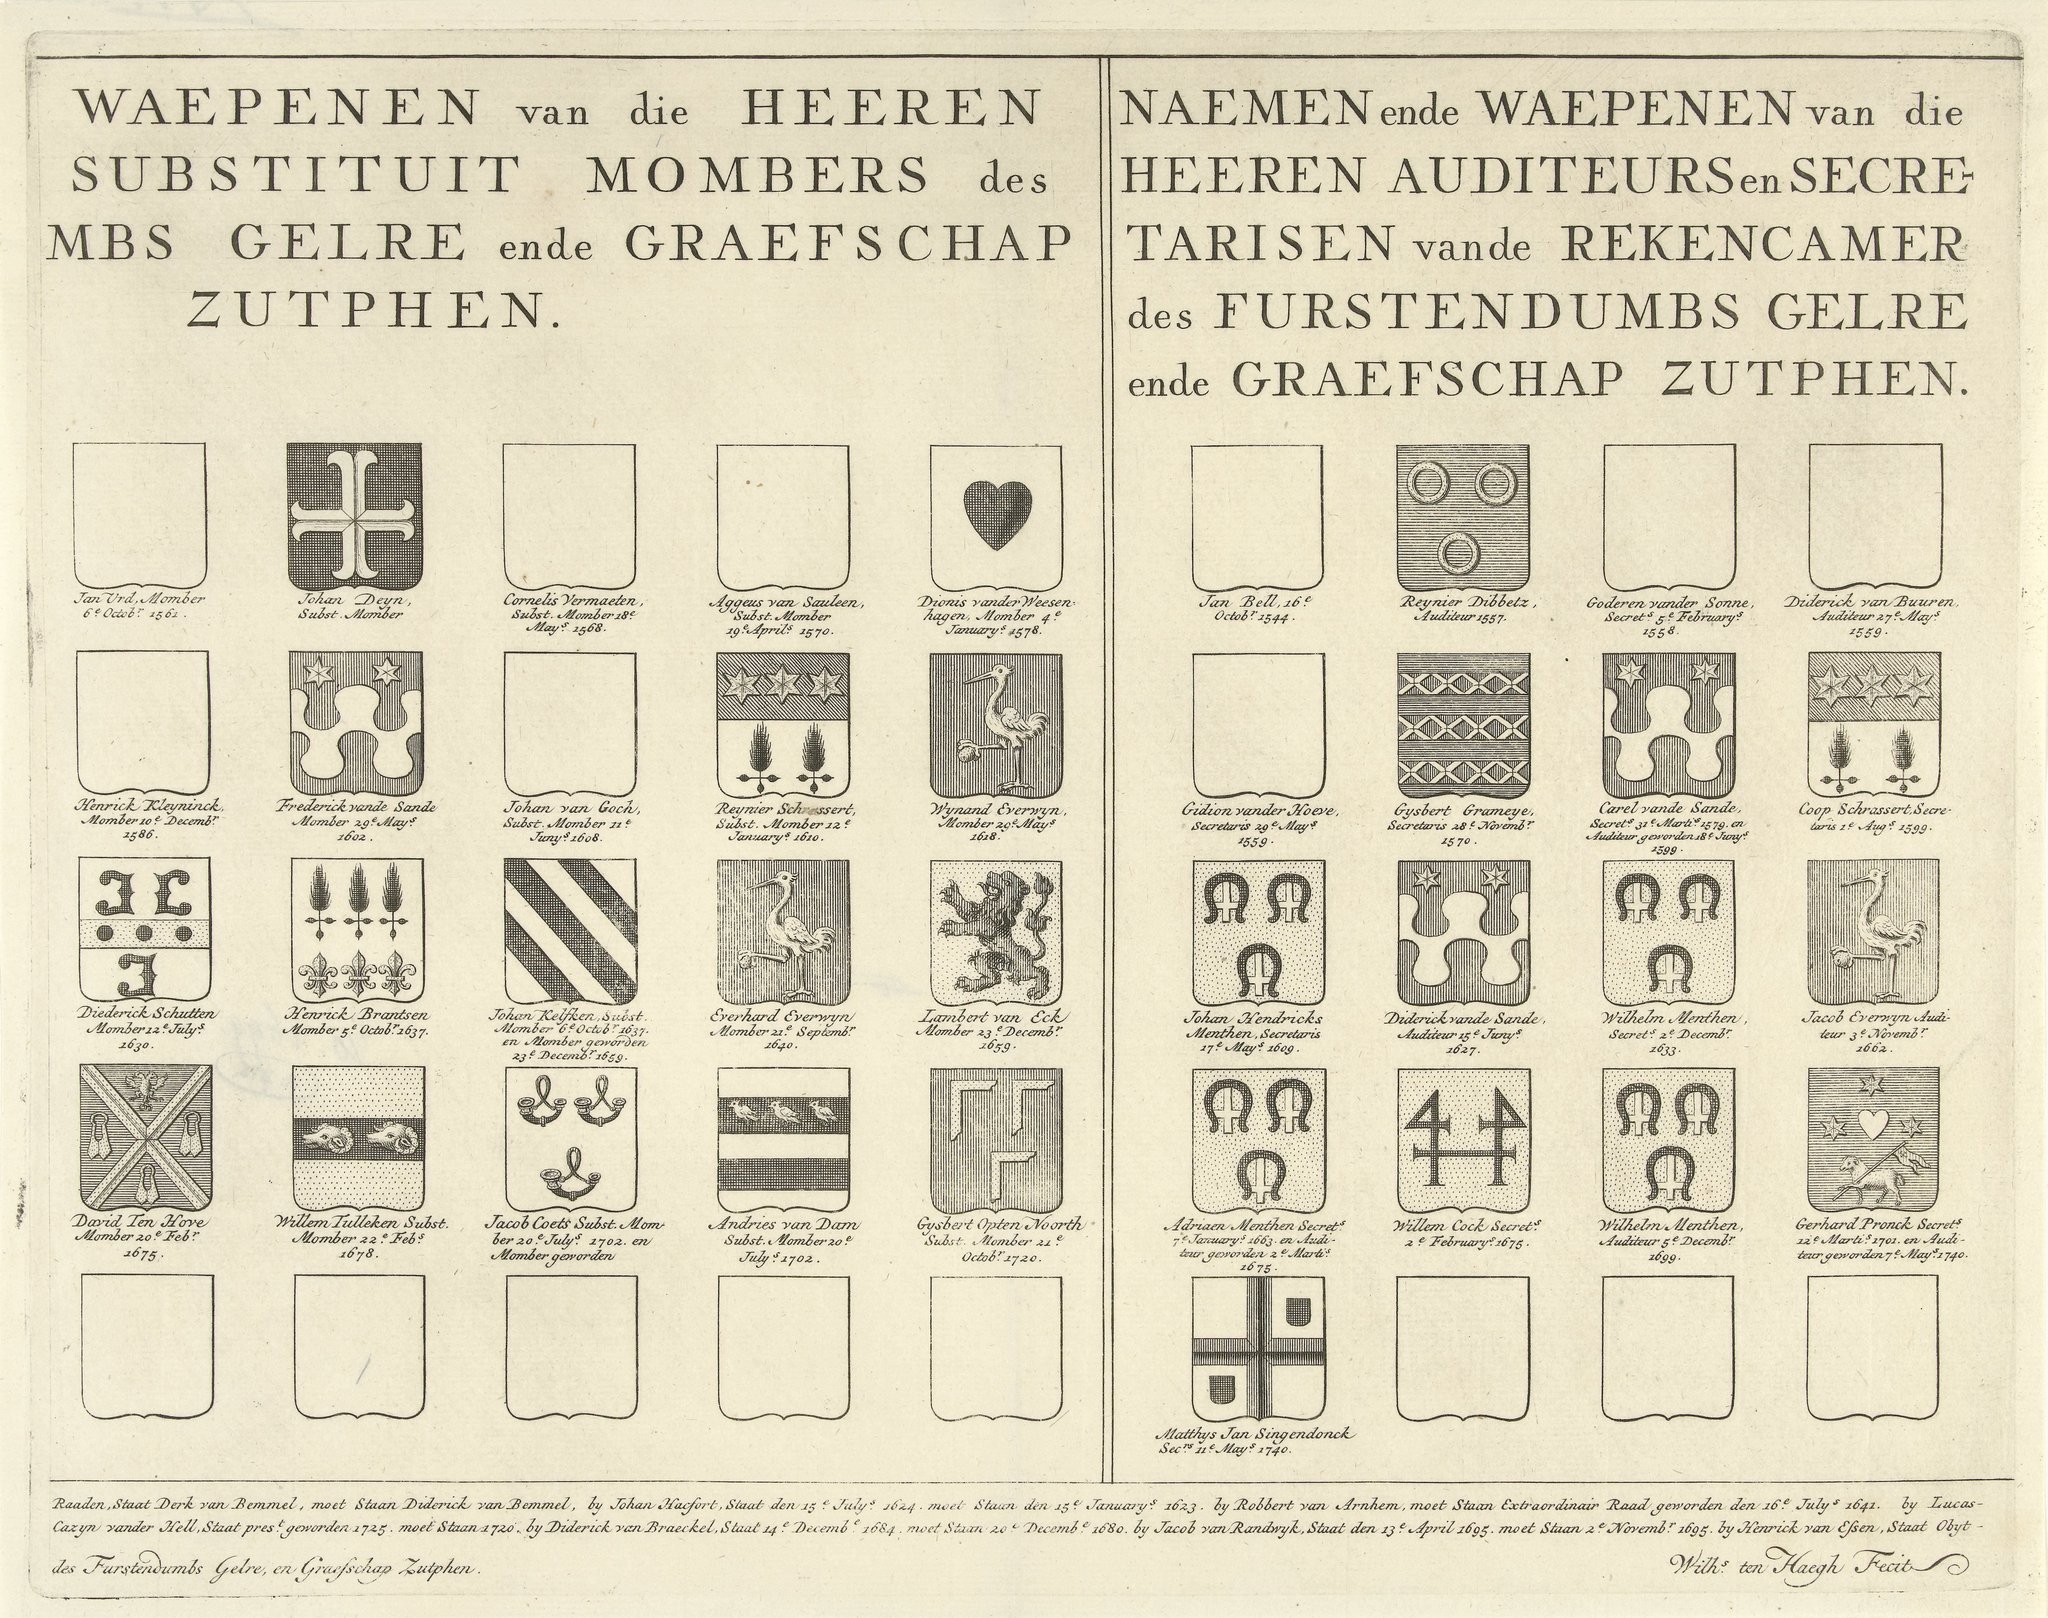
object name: print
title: Namen en wapens in het vorstendom Gelre en het graafschap Zutphen, blad rechtsonder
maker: wilhelmus ten haegh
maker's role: print maker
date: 1700-1799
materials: paper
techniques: engraving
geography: low countries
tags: armorial bearing, heraldry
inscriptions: collector's mark: Lugt 2228